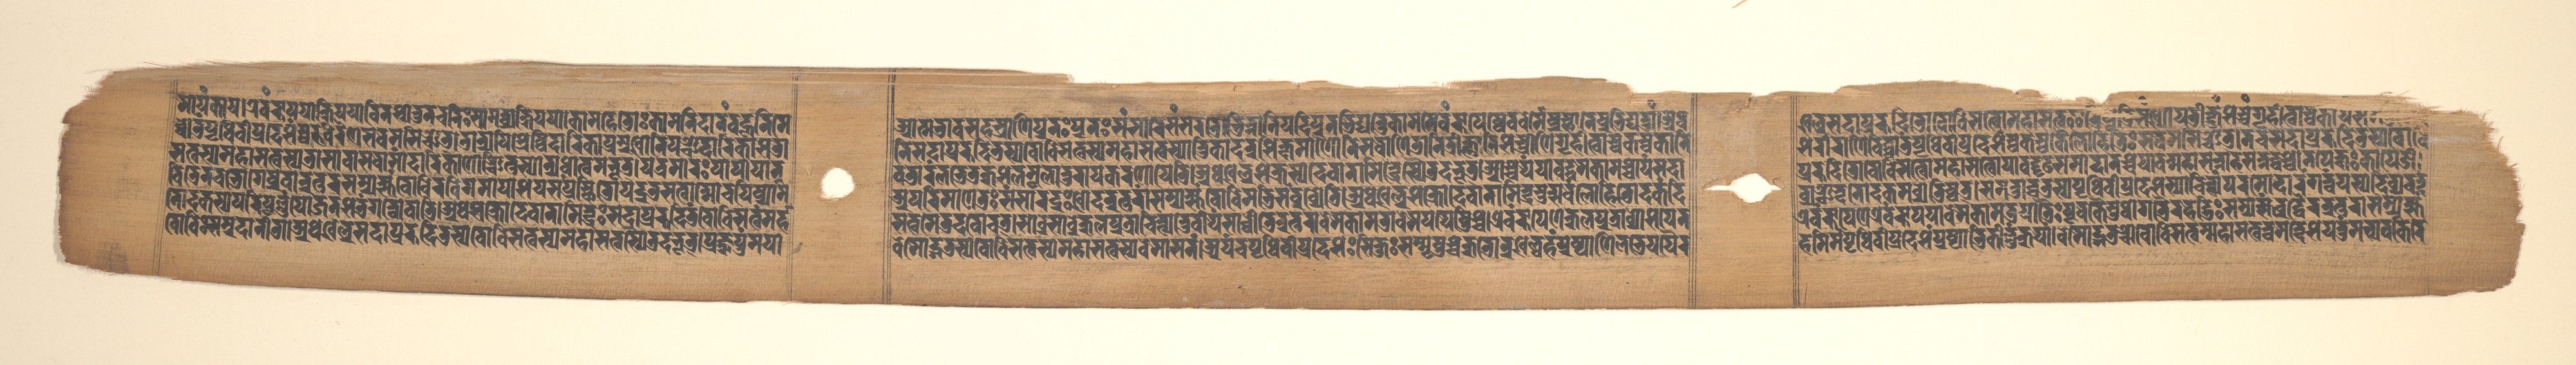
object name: folio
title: Folio from a Buddhist Manuscript of Pancavimsatisahasrika Prajnaparamita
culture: indian, bengal or bangladesh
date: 1090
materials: leaf, watercolor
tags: buddhism